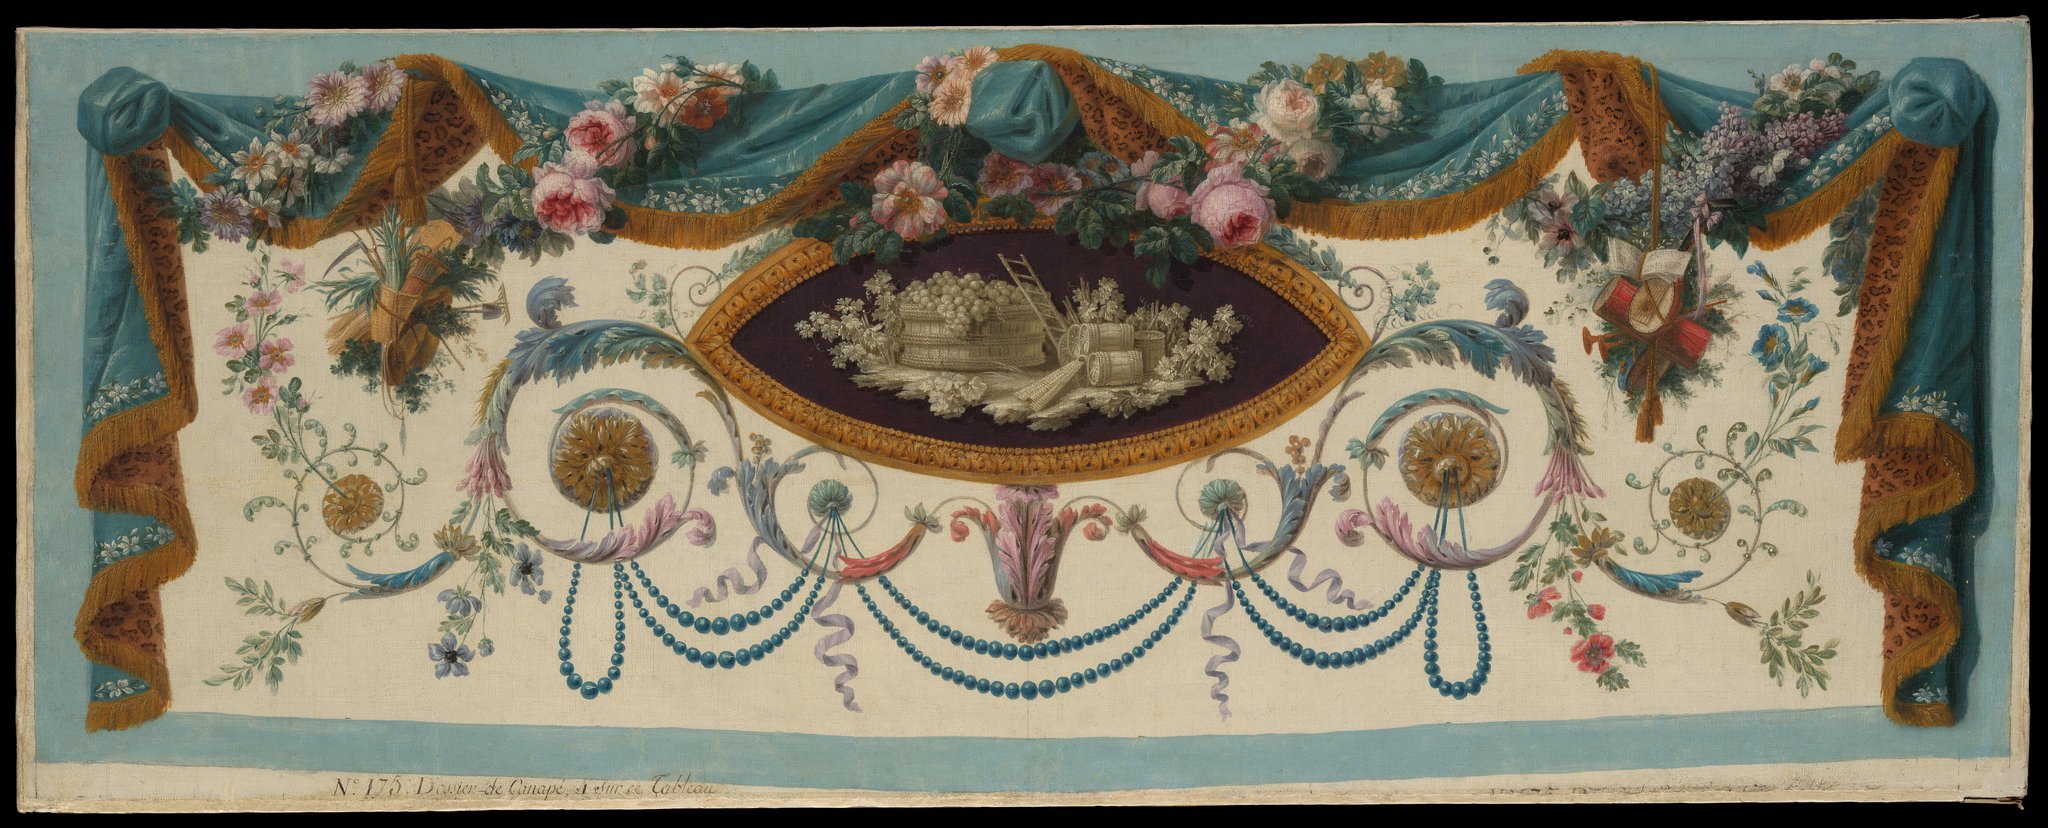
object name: painting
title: Cartoon for the Back of a Tapestry Settee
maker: french painter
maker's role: artist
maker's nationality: french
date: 1775-1799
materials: canvas, oil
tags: garlands,flowers